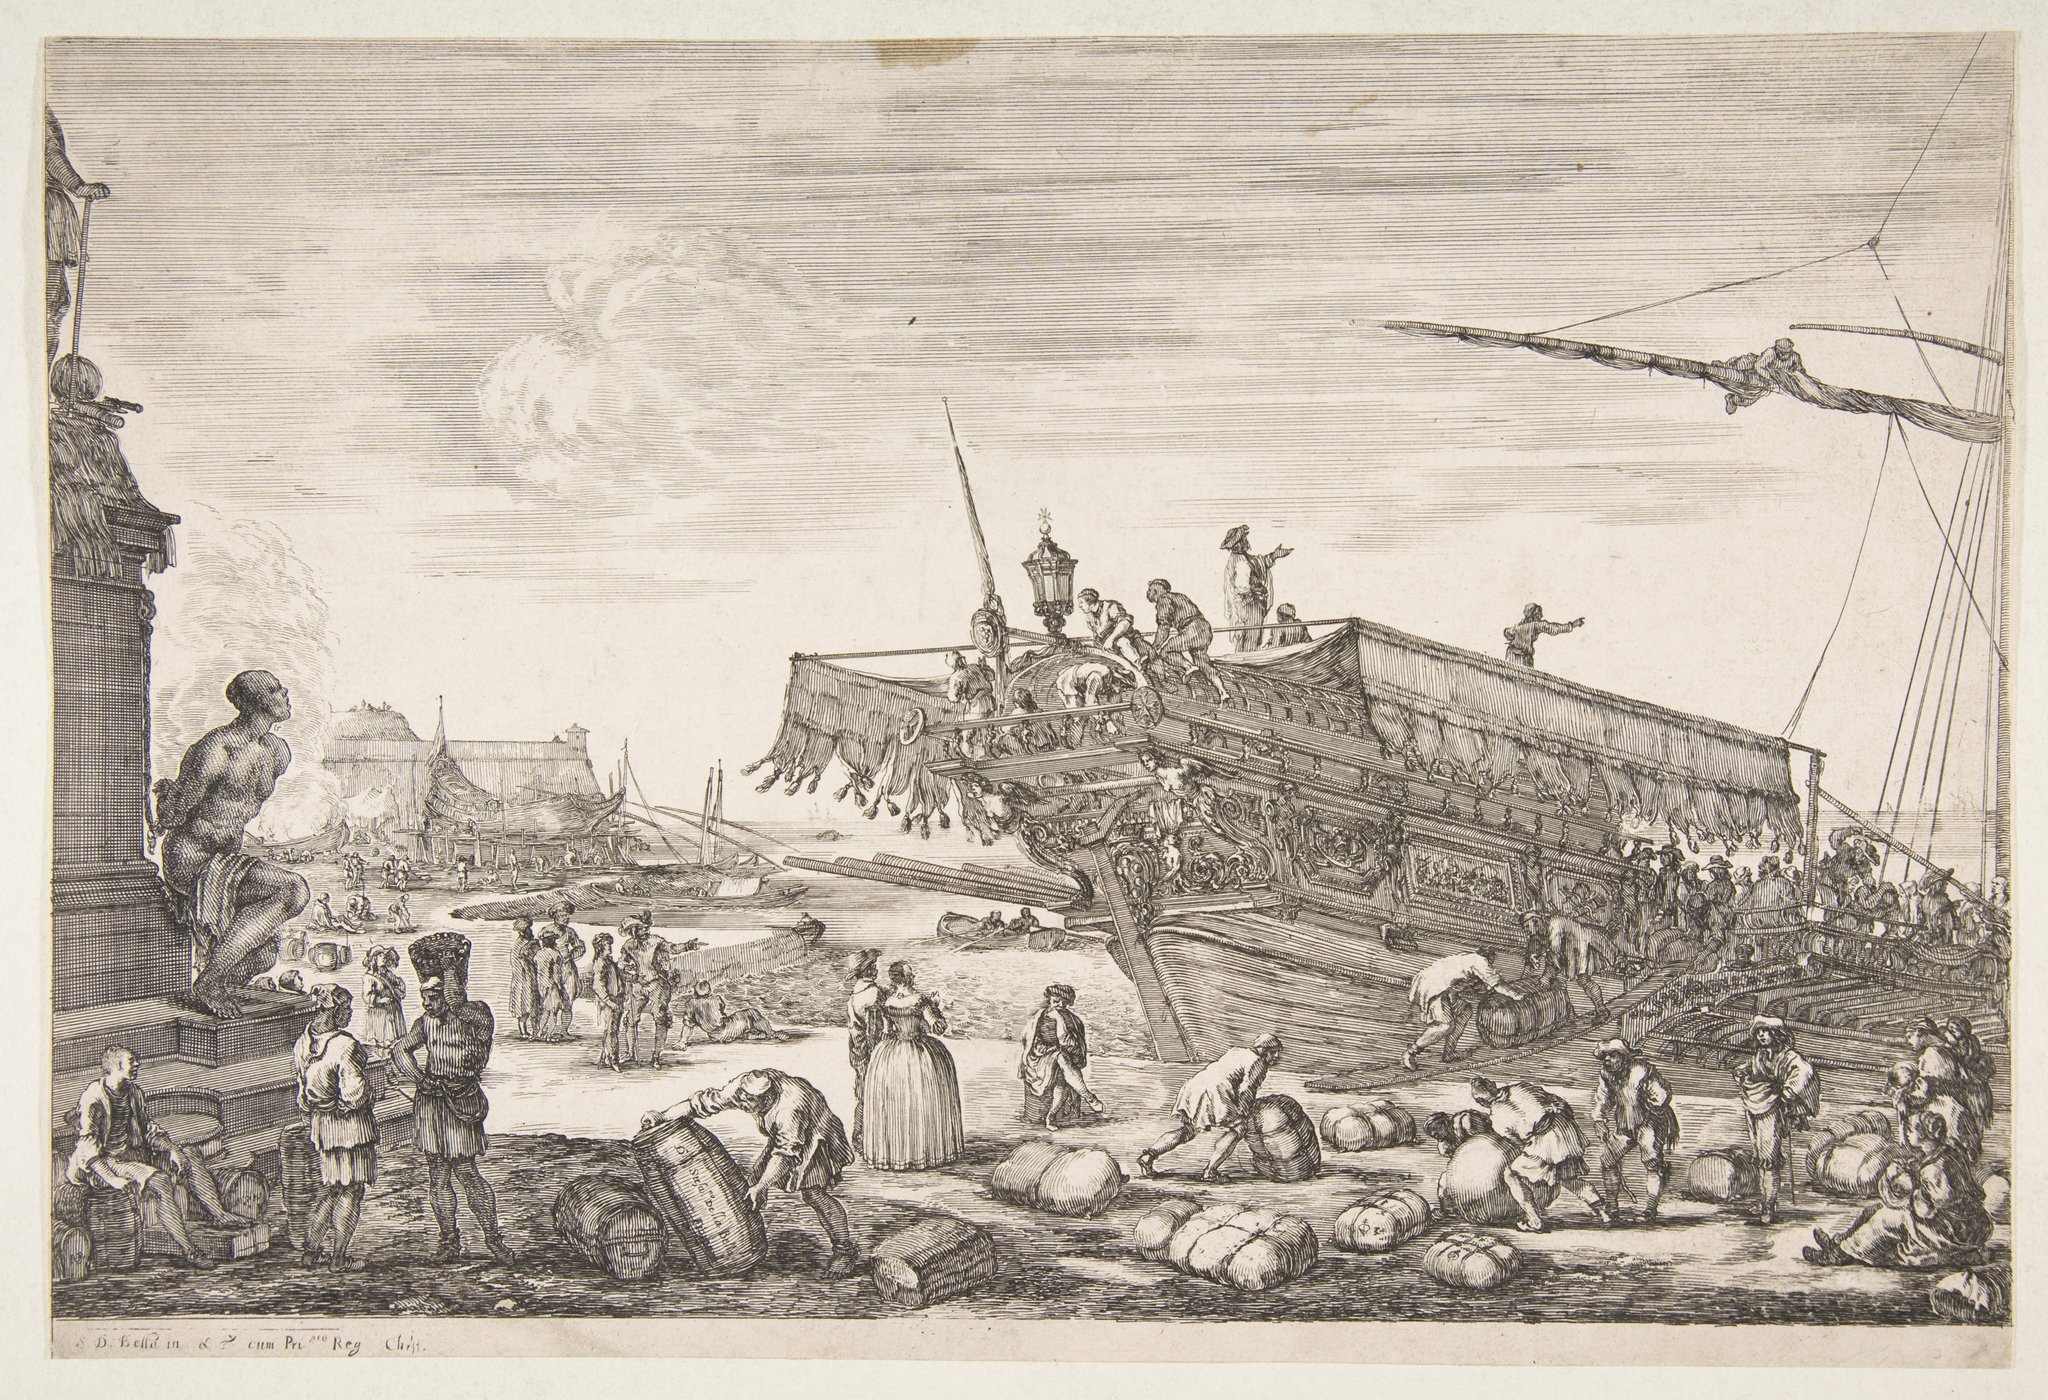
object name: print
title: Loading a galley, from "Views of the port of Livorno" (Vues du port de Livourne)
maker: stefano della bella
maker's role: artist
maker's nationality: italian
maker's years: 1610-1664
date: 1654-1655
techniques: etching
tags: men,women,working,ships